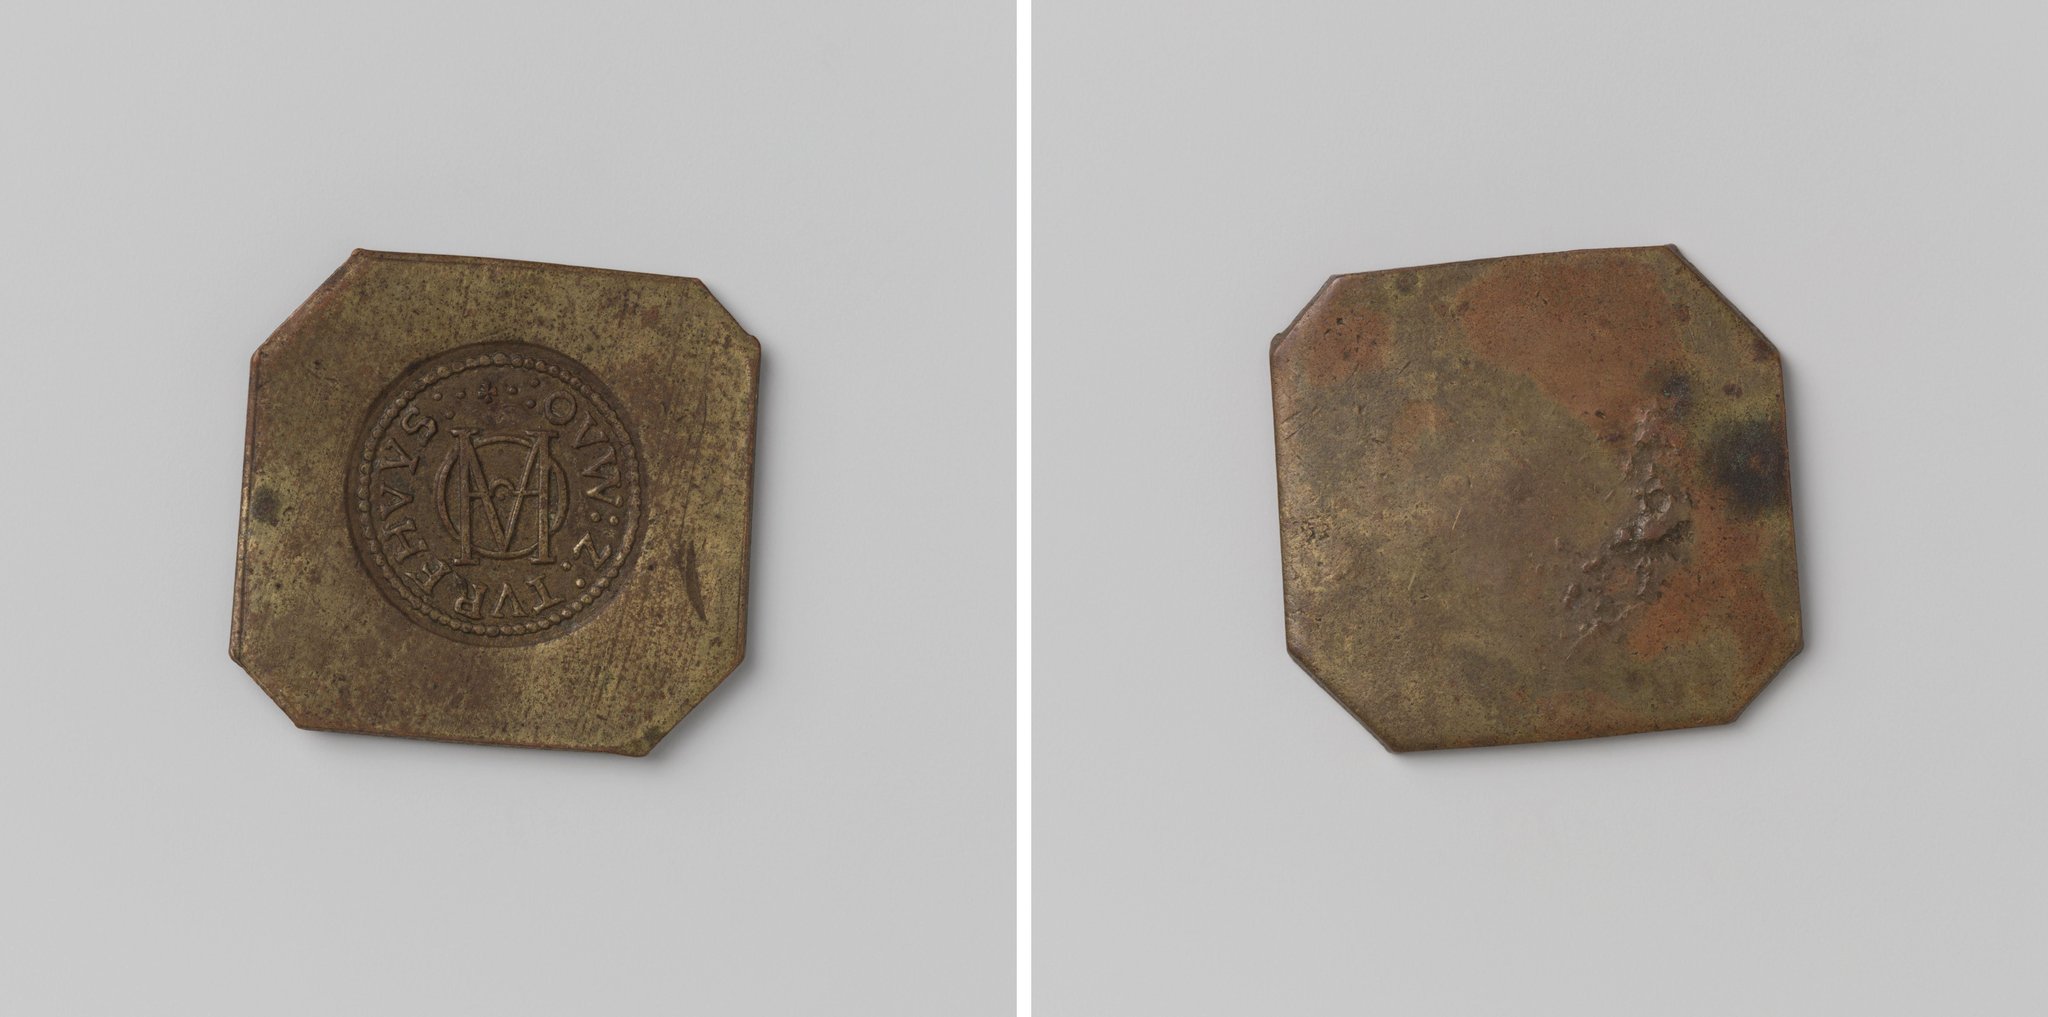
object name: alms token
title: Oudezijds Armhuis te Amsterdam, armenpenning die bij uitdeling recht gaf op turf uit het turfhuis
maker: Anonymous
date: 1698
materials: brass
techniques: striking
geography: amsterdam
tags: amsterdam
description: Enkelzijdige messing achthoekige armenpenning. Voorzijde: in ronde parelrand: monogram van letters O, A en H binnen omschrift. Keerzijde: blanco.